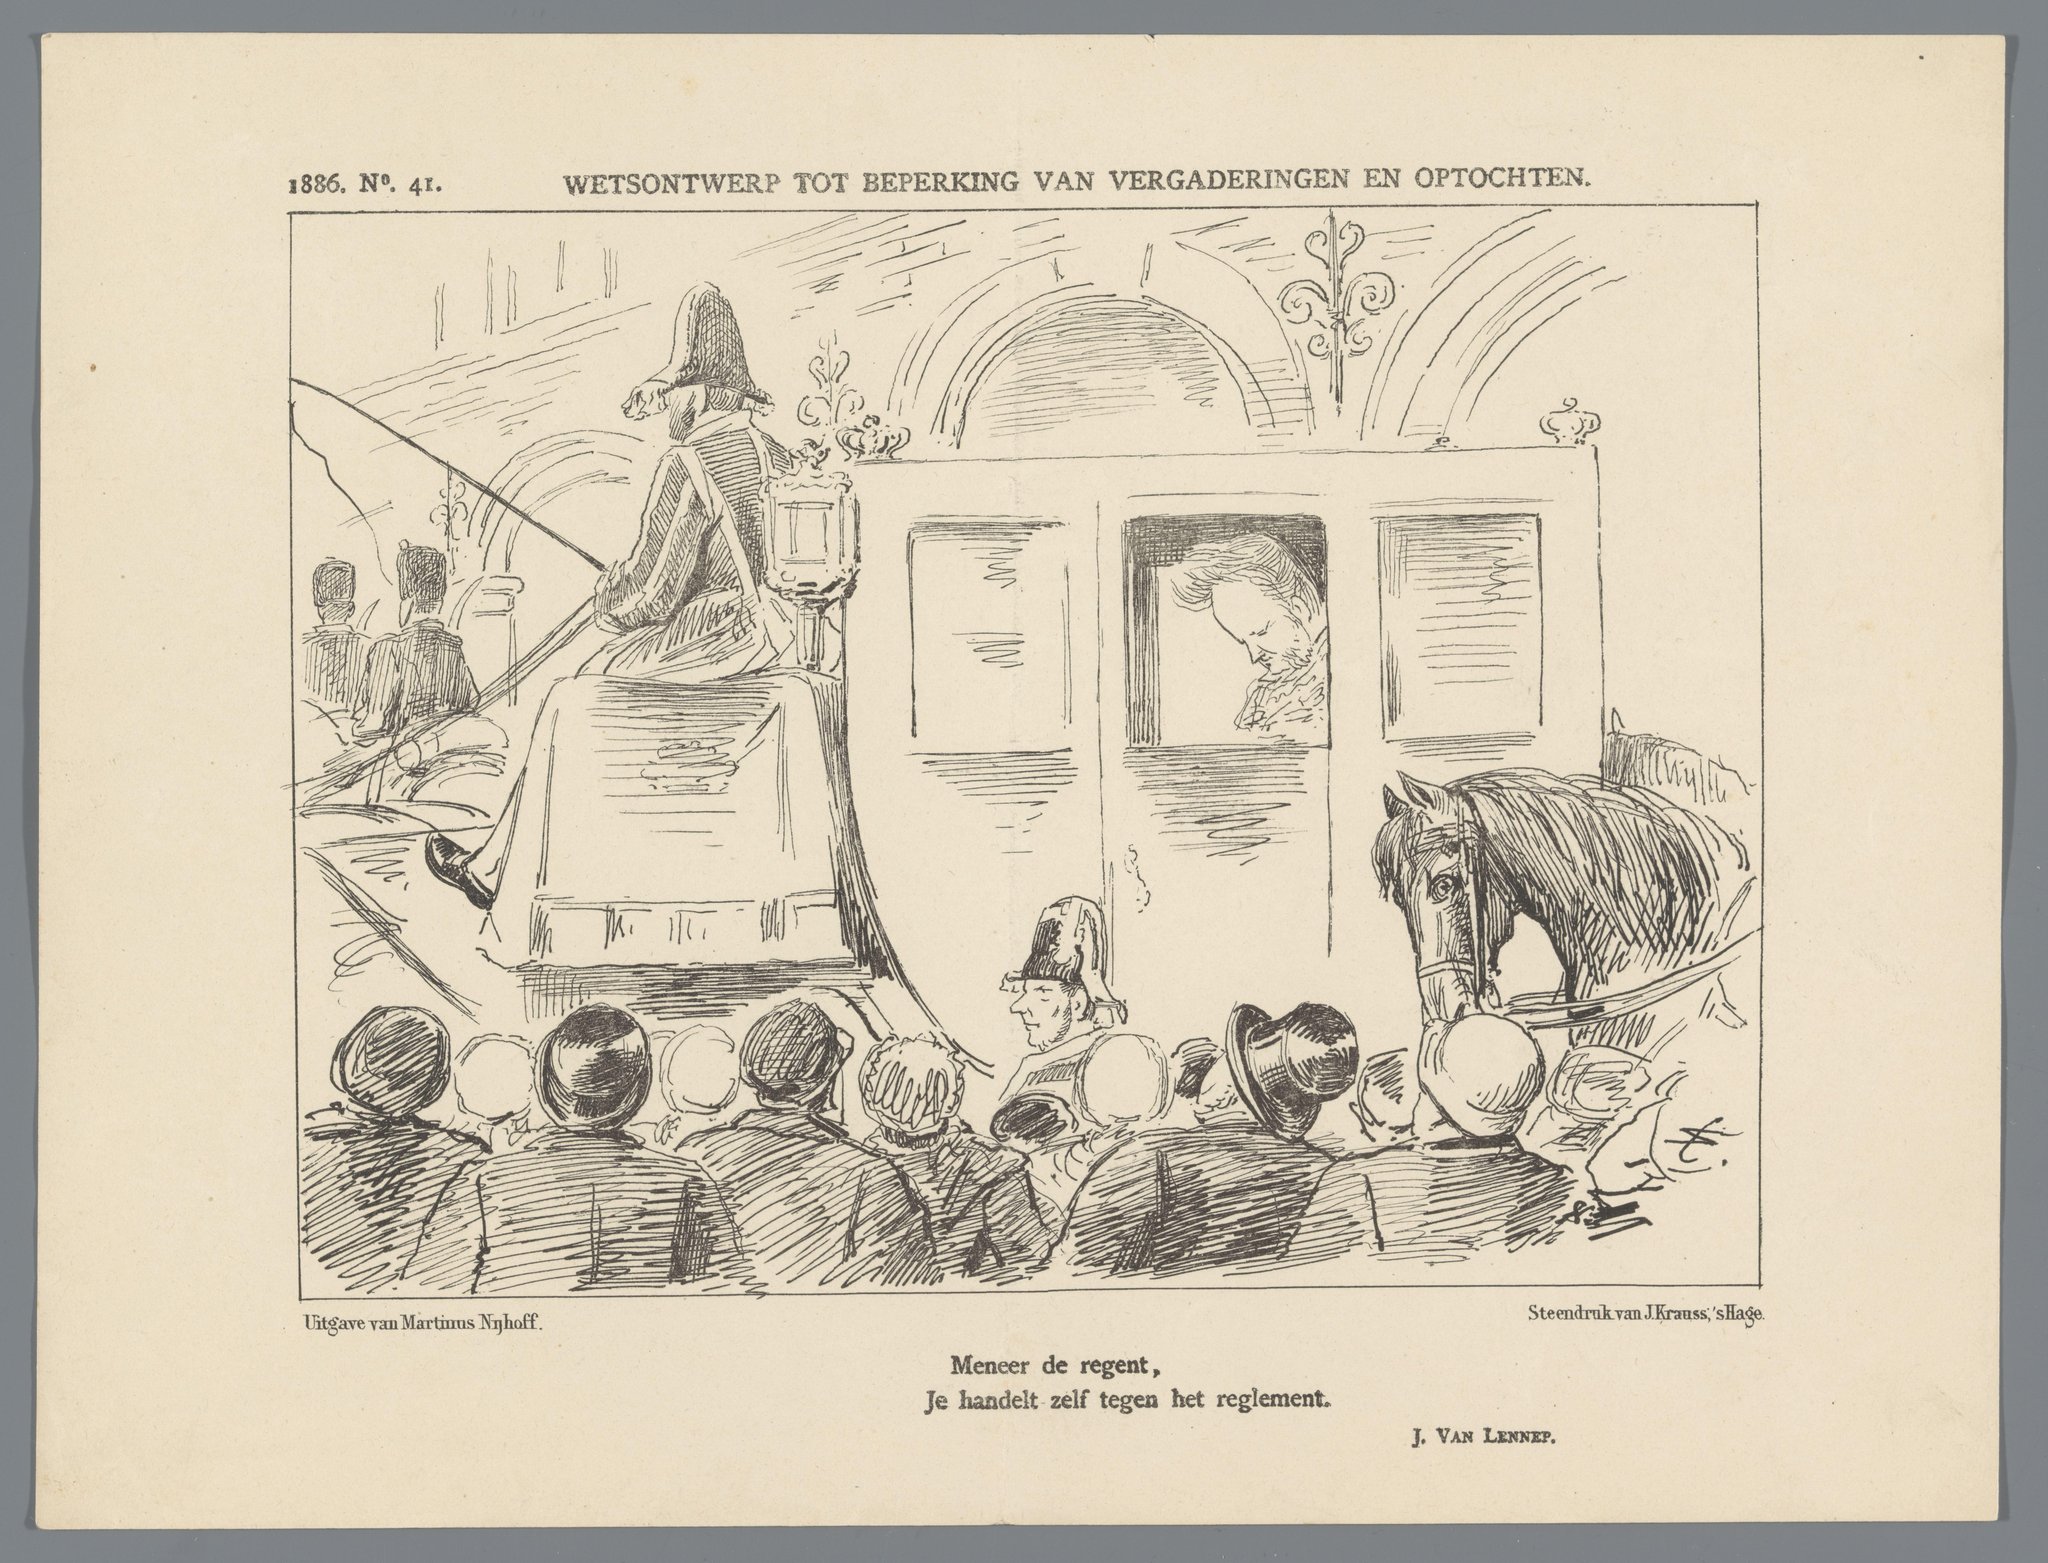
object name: print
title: Spotprent nav het wetsontwerp tot beperking van vergaderingen en optochten, 1886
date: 1886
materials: paper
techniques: lithograph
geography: the hague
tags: amsterdam, politician, the hague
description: Spotprent nav het wetsontwerp tot beperking van vergaderingen en optochten. Minister Kuiper in een koets bij Prinsjesdag. Plaat verschenen bij het weekblad De Nederlandsche Spectator, nr. 41, 1886.